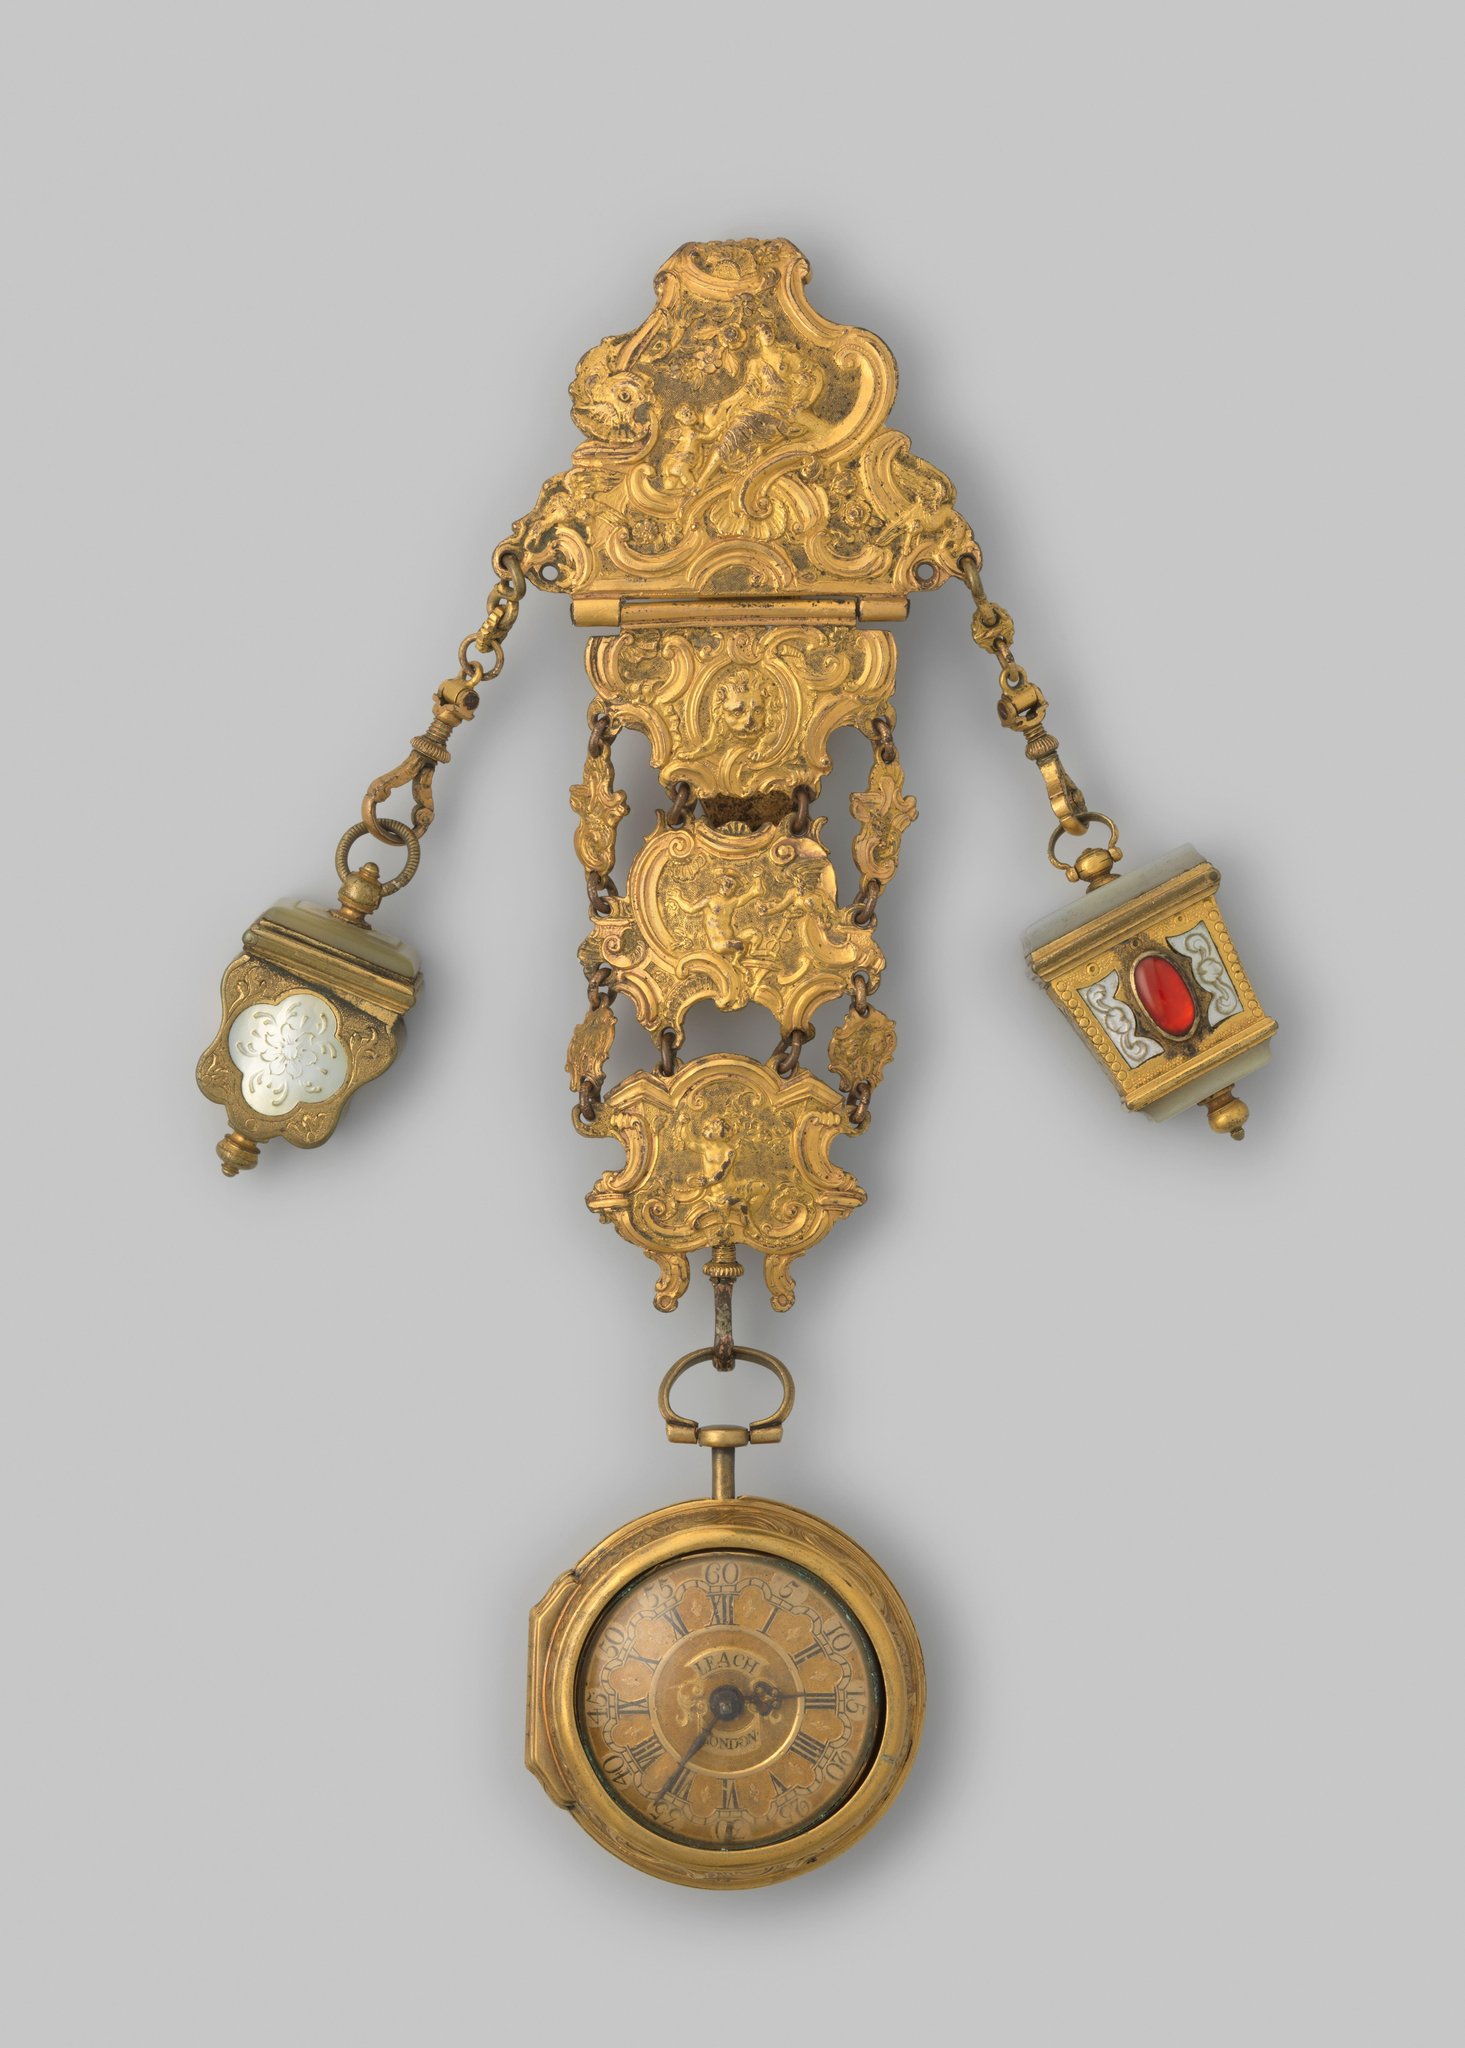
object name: jewellery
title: Horloge van goud met geciseleerde wijzerplaat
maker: leach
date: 1750-1800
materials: gold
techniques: metalworking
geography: london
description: Gouden horloge met een geciseleerde wijzerplaat. De kast is gedreven met een voorstelling van een knielende man voor een vrouw. Hangt aan chatelaine BK-NM-12830-B.